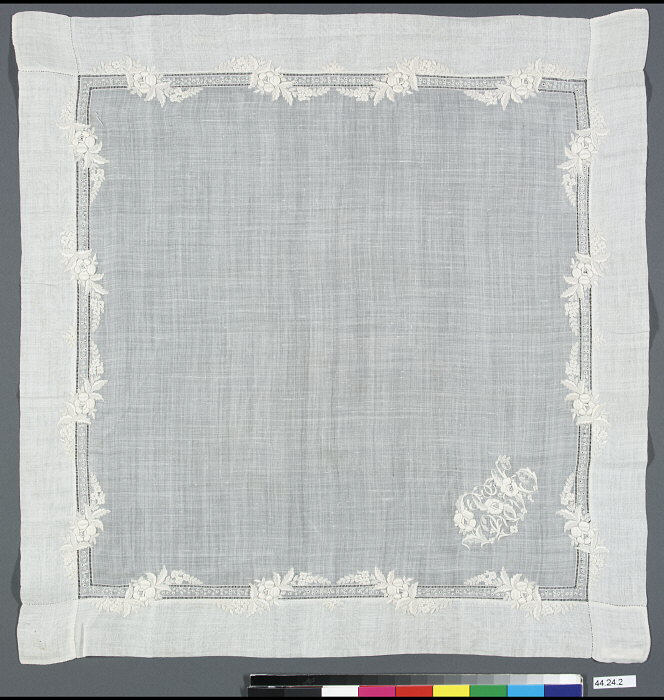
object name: handkerchief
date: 1801-1900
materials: linen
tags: flowers